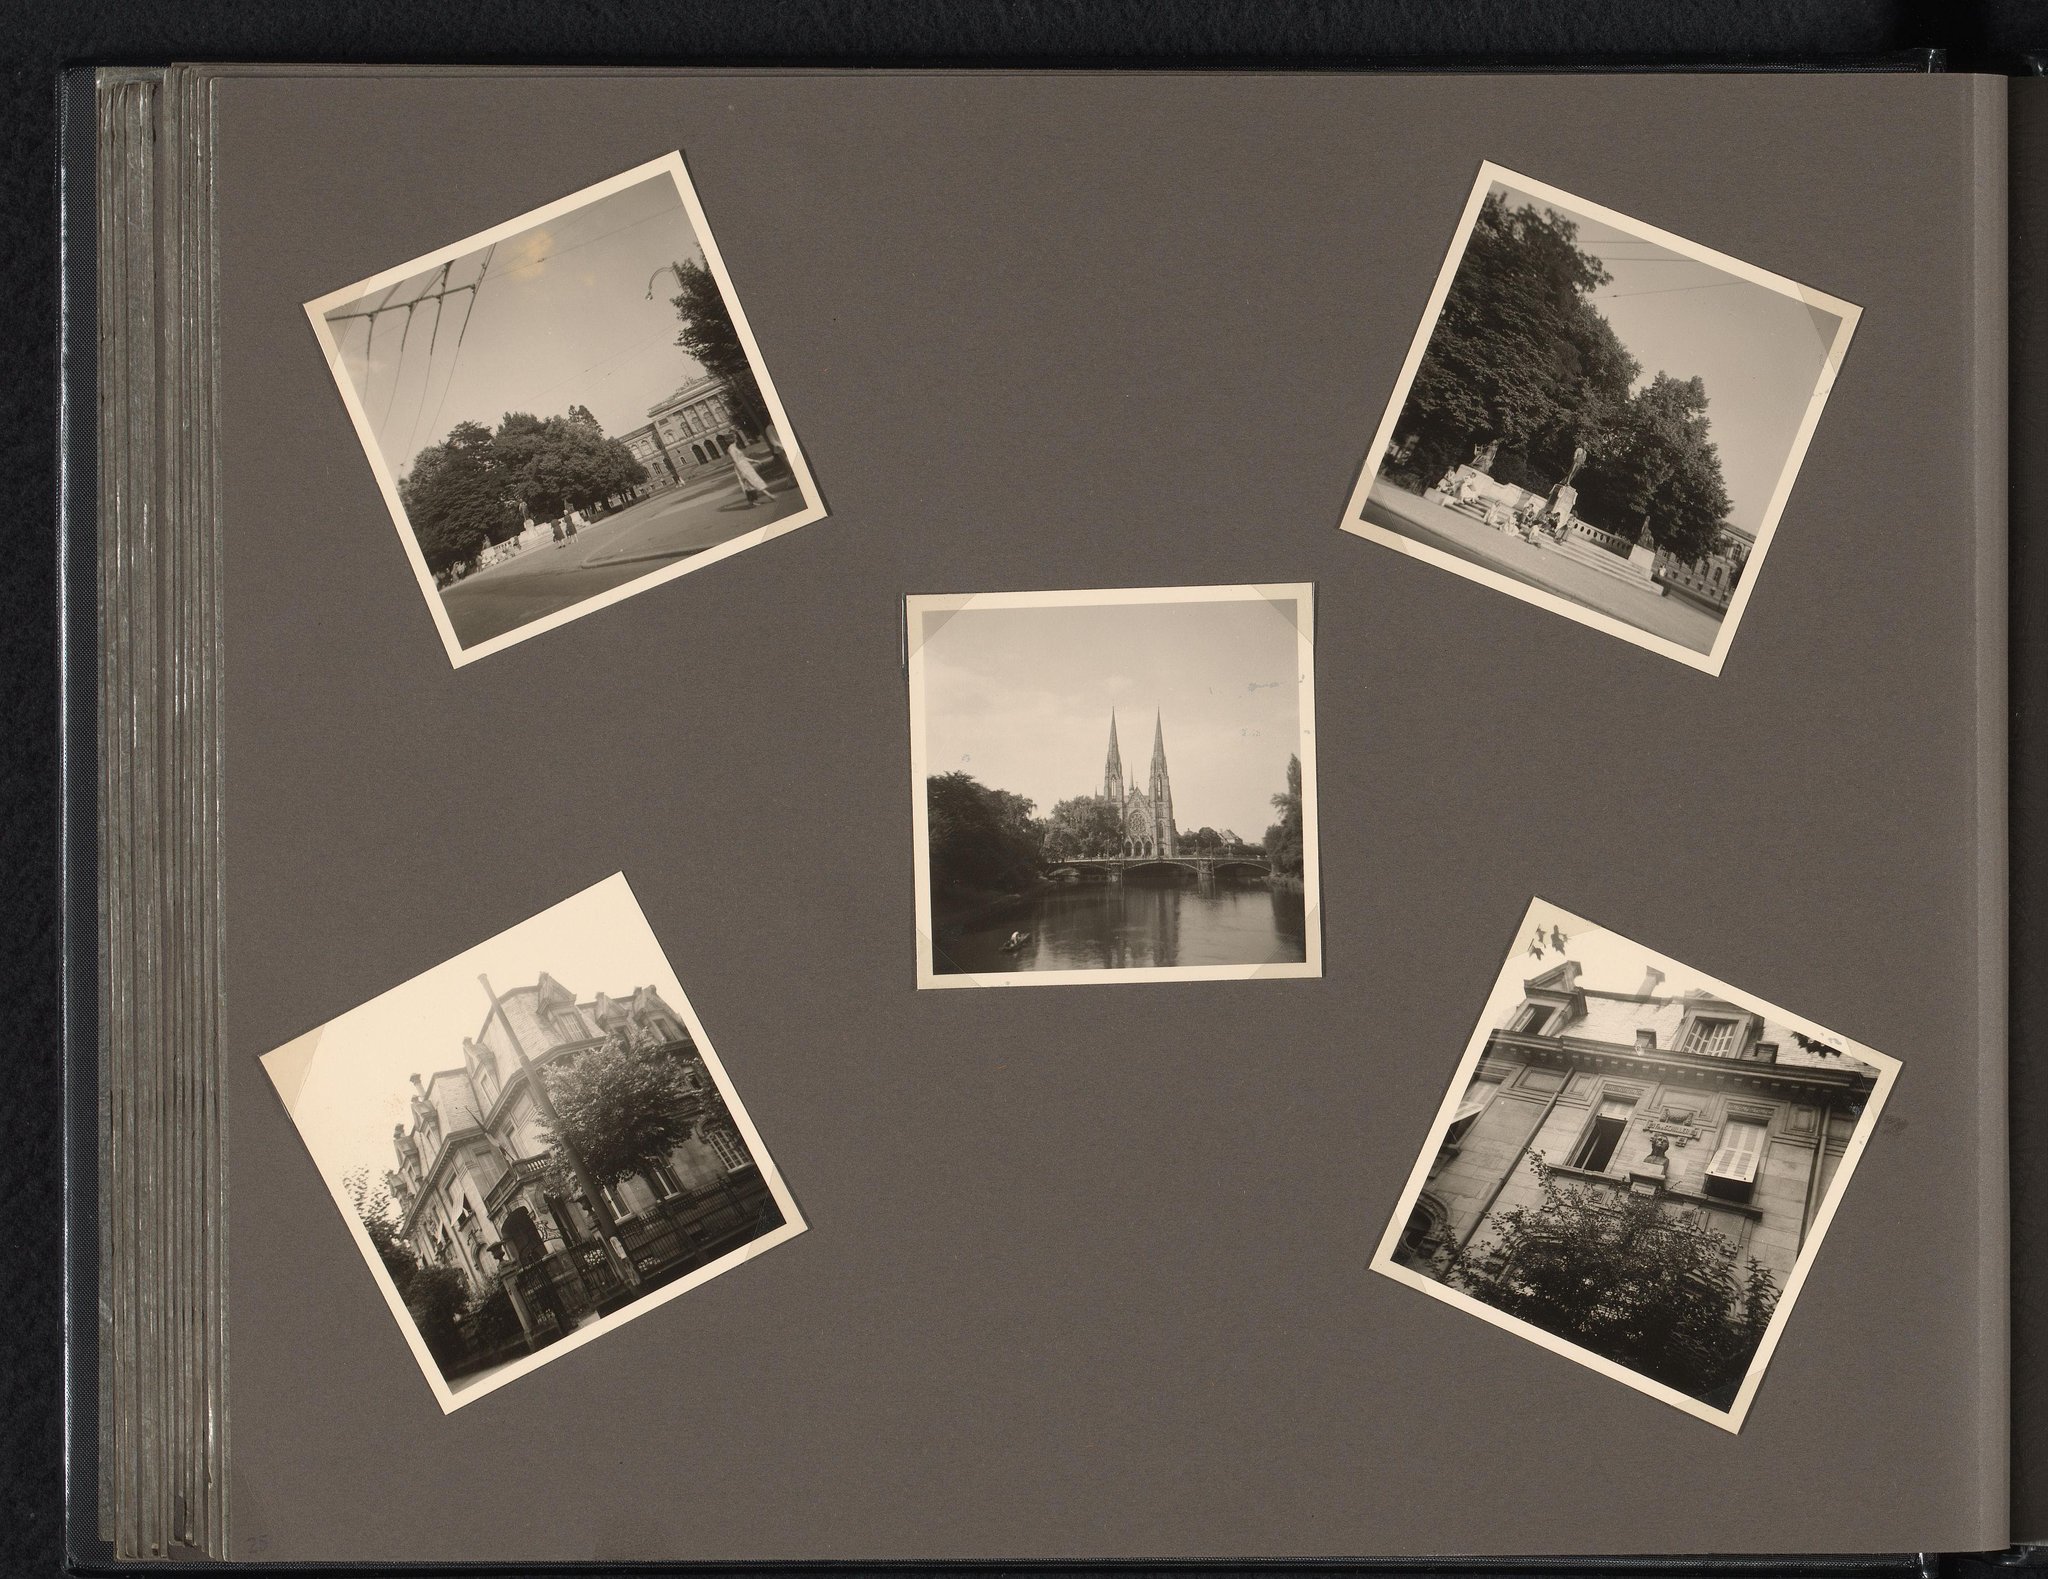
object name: album leaf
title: Stadsgezichten in Straatsburg, Frankrijk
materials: paper, cardboard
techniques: gelatin silver print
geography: straatsburg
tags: square, place, circus, etc., church (exterior), bridge in city across river, canal, etc.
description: Blad bevat vijf foto's. Deze foto's maken deel uit van een album.